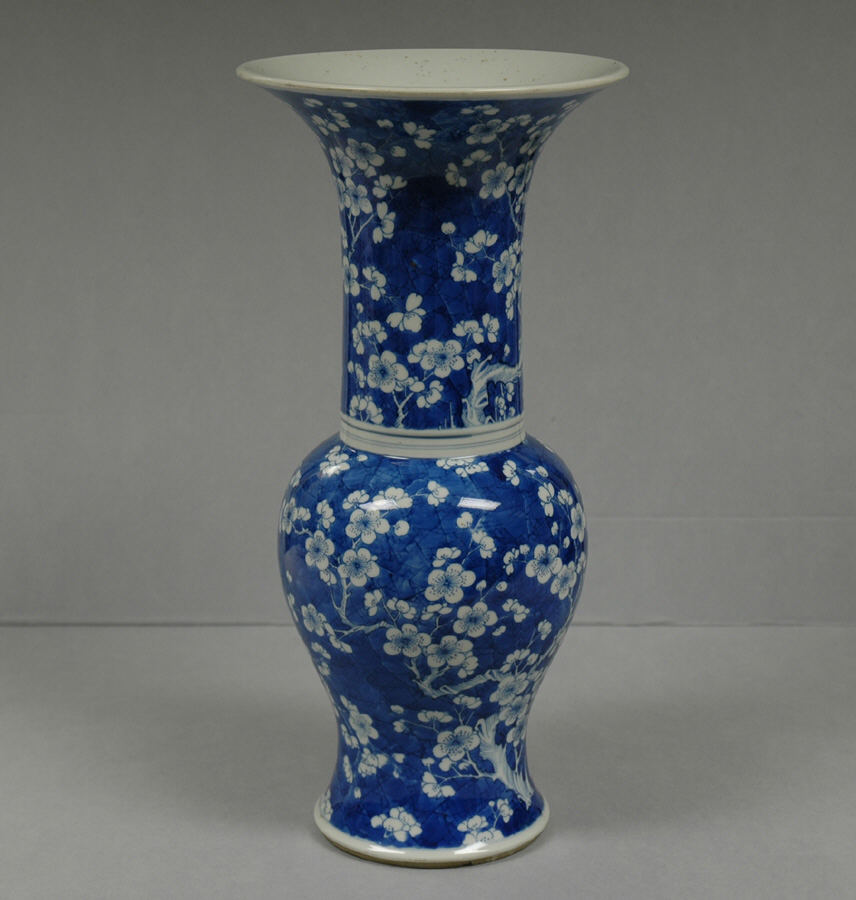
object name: vase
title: Vase decorated with blossoming plum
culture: chinese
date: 1662-1722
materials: cobalt, glaze, porcelain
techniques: painting